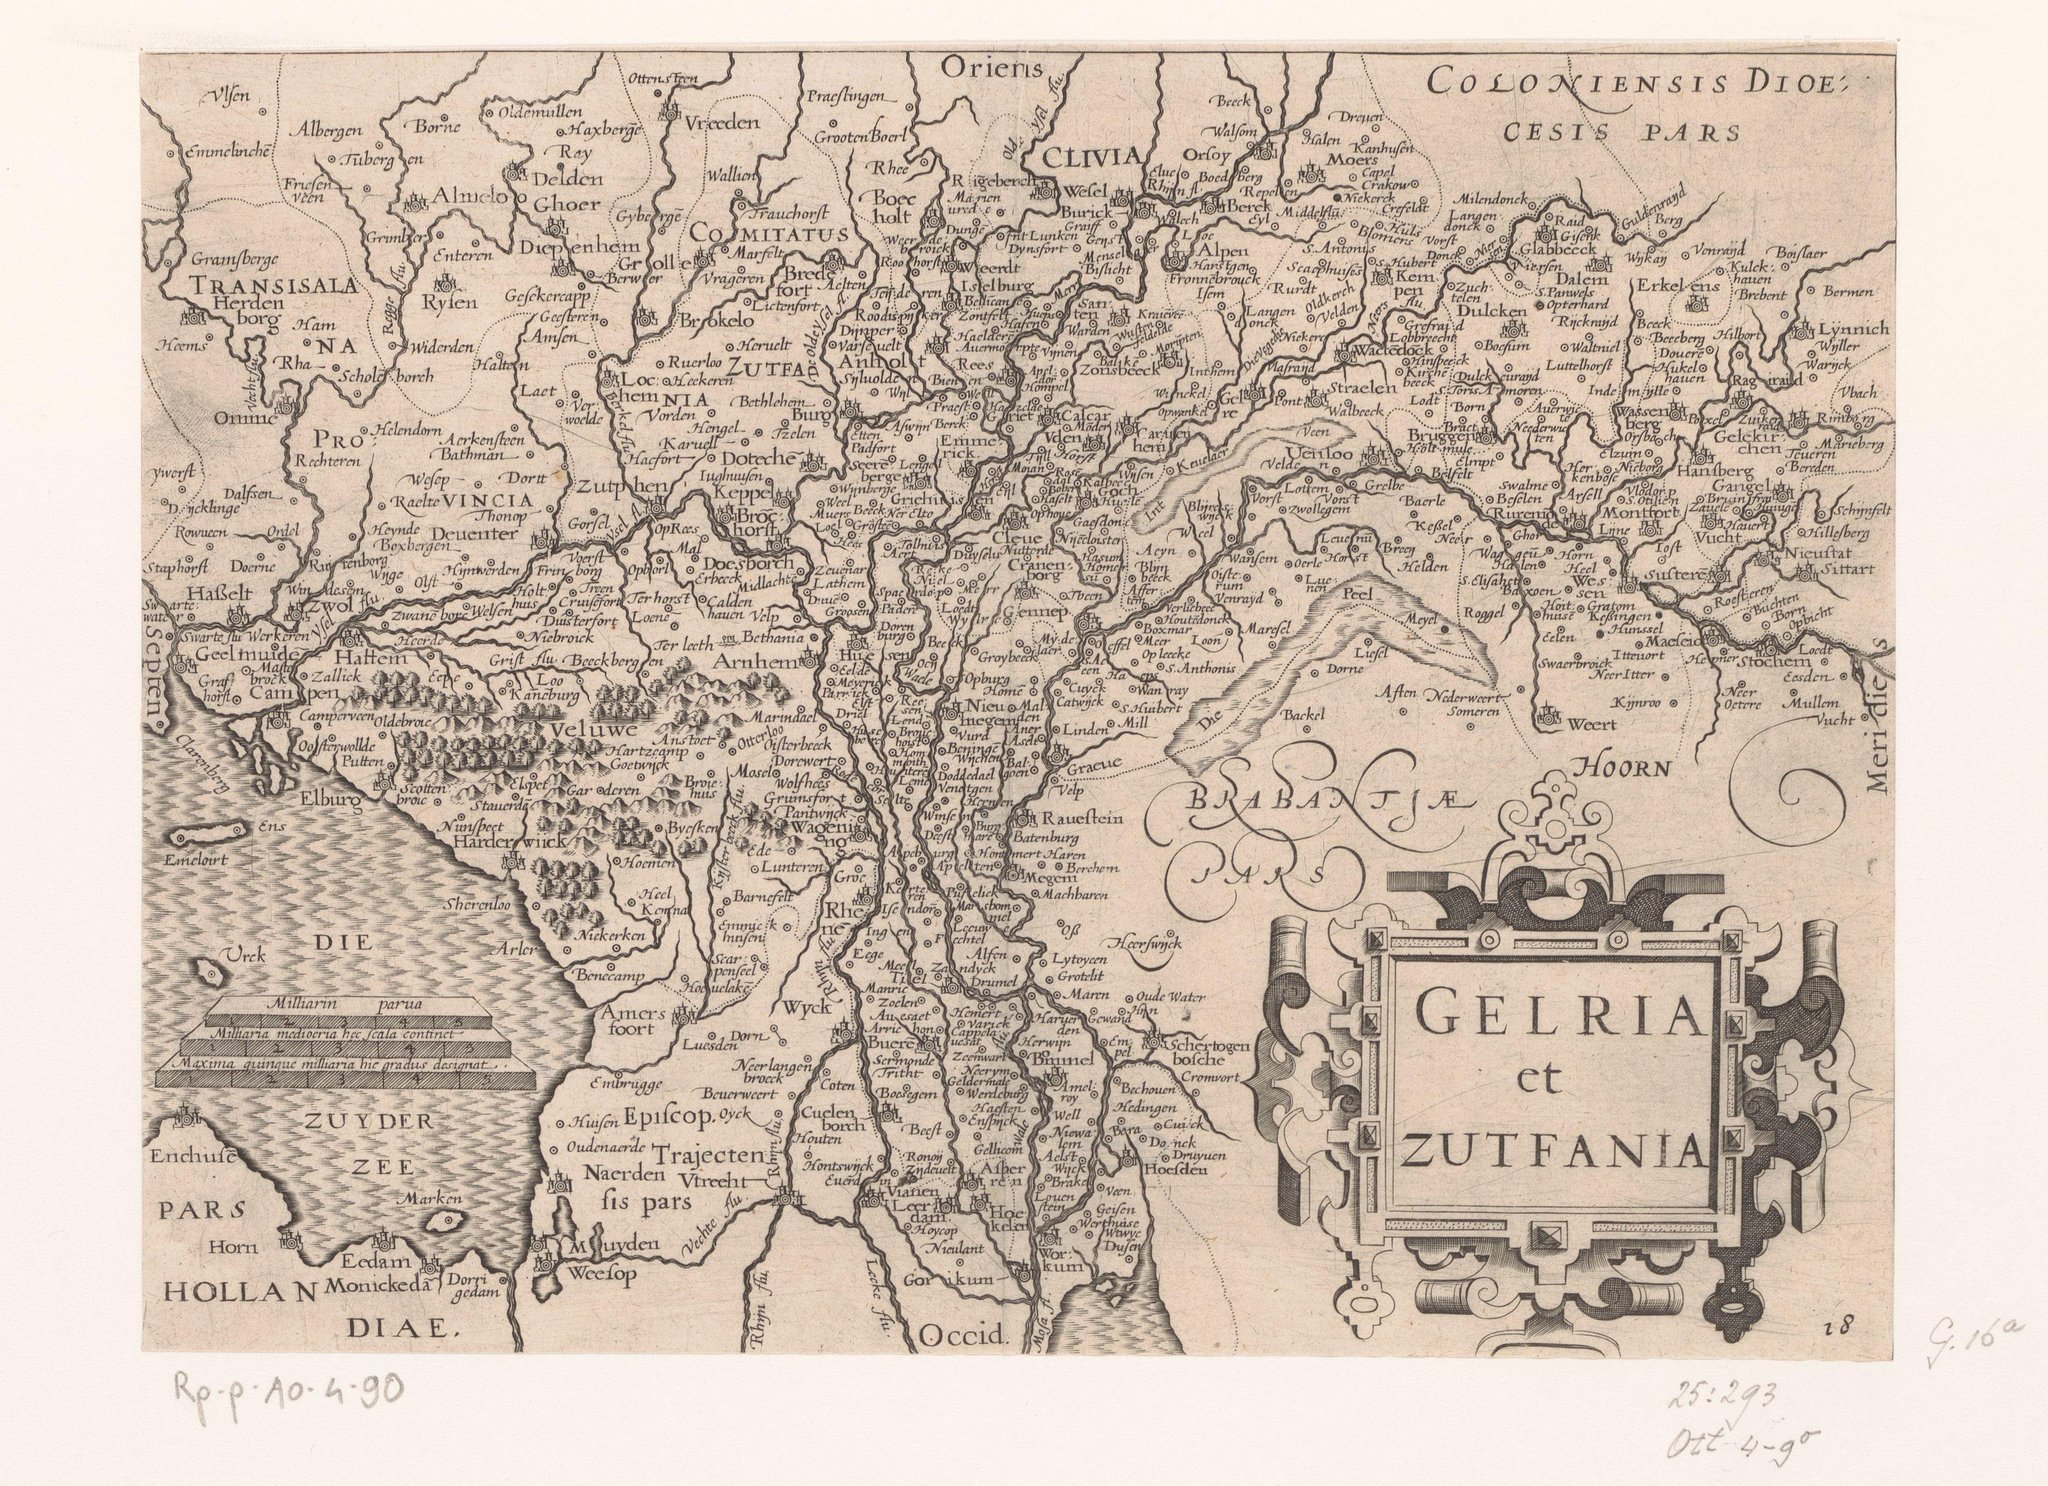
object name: print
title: Gelria et Zutfania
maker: Anonymous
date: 1609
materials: paper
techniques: engraving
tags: maps of separate countries or regions, gelderland, guelders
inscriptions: collector's mark: Lugt 2228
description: Deze staat van prent voor het eerst gebruikt in: Guicciardini, Lodovico. Beschryvinghe van alle de Neder-landen, anderssins ghenoemt Neder-Duytslandt (…). Amsterdam: Willem Janszoon Blaeu, 1612. Hierna is deze prent tot 1648 nog gebruikt in latere uitgaven van deze publicatie, uitgegeven door Blaeu en daarna door Janssonius. Uit welke uitgave het huidige exemplaar precies komt is niet na te gaan.